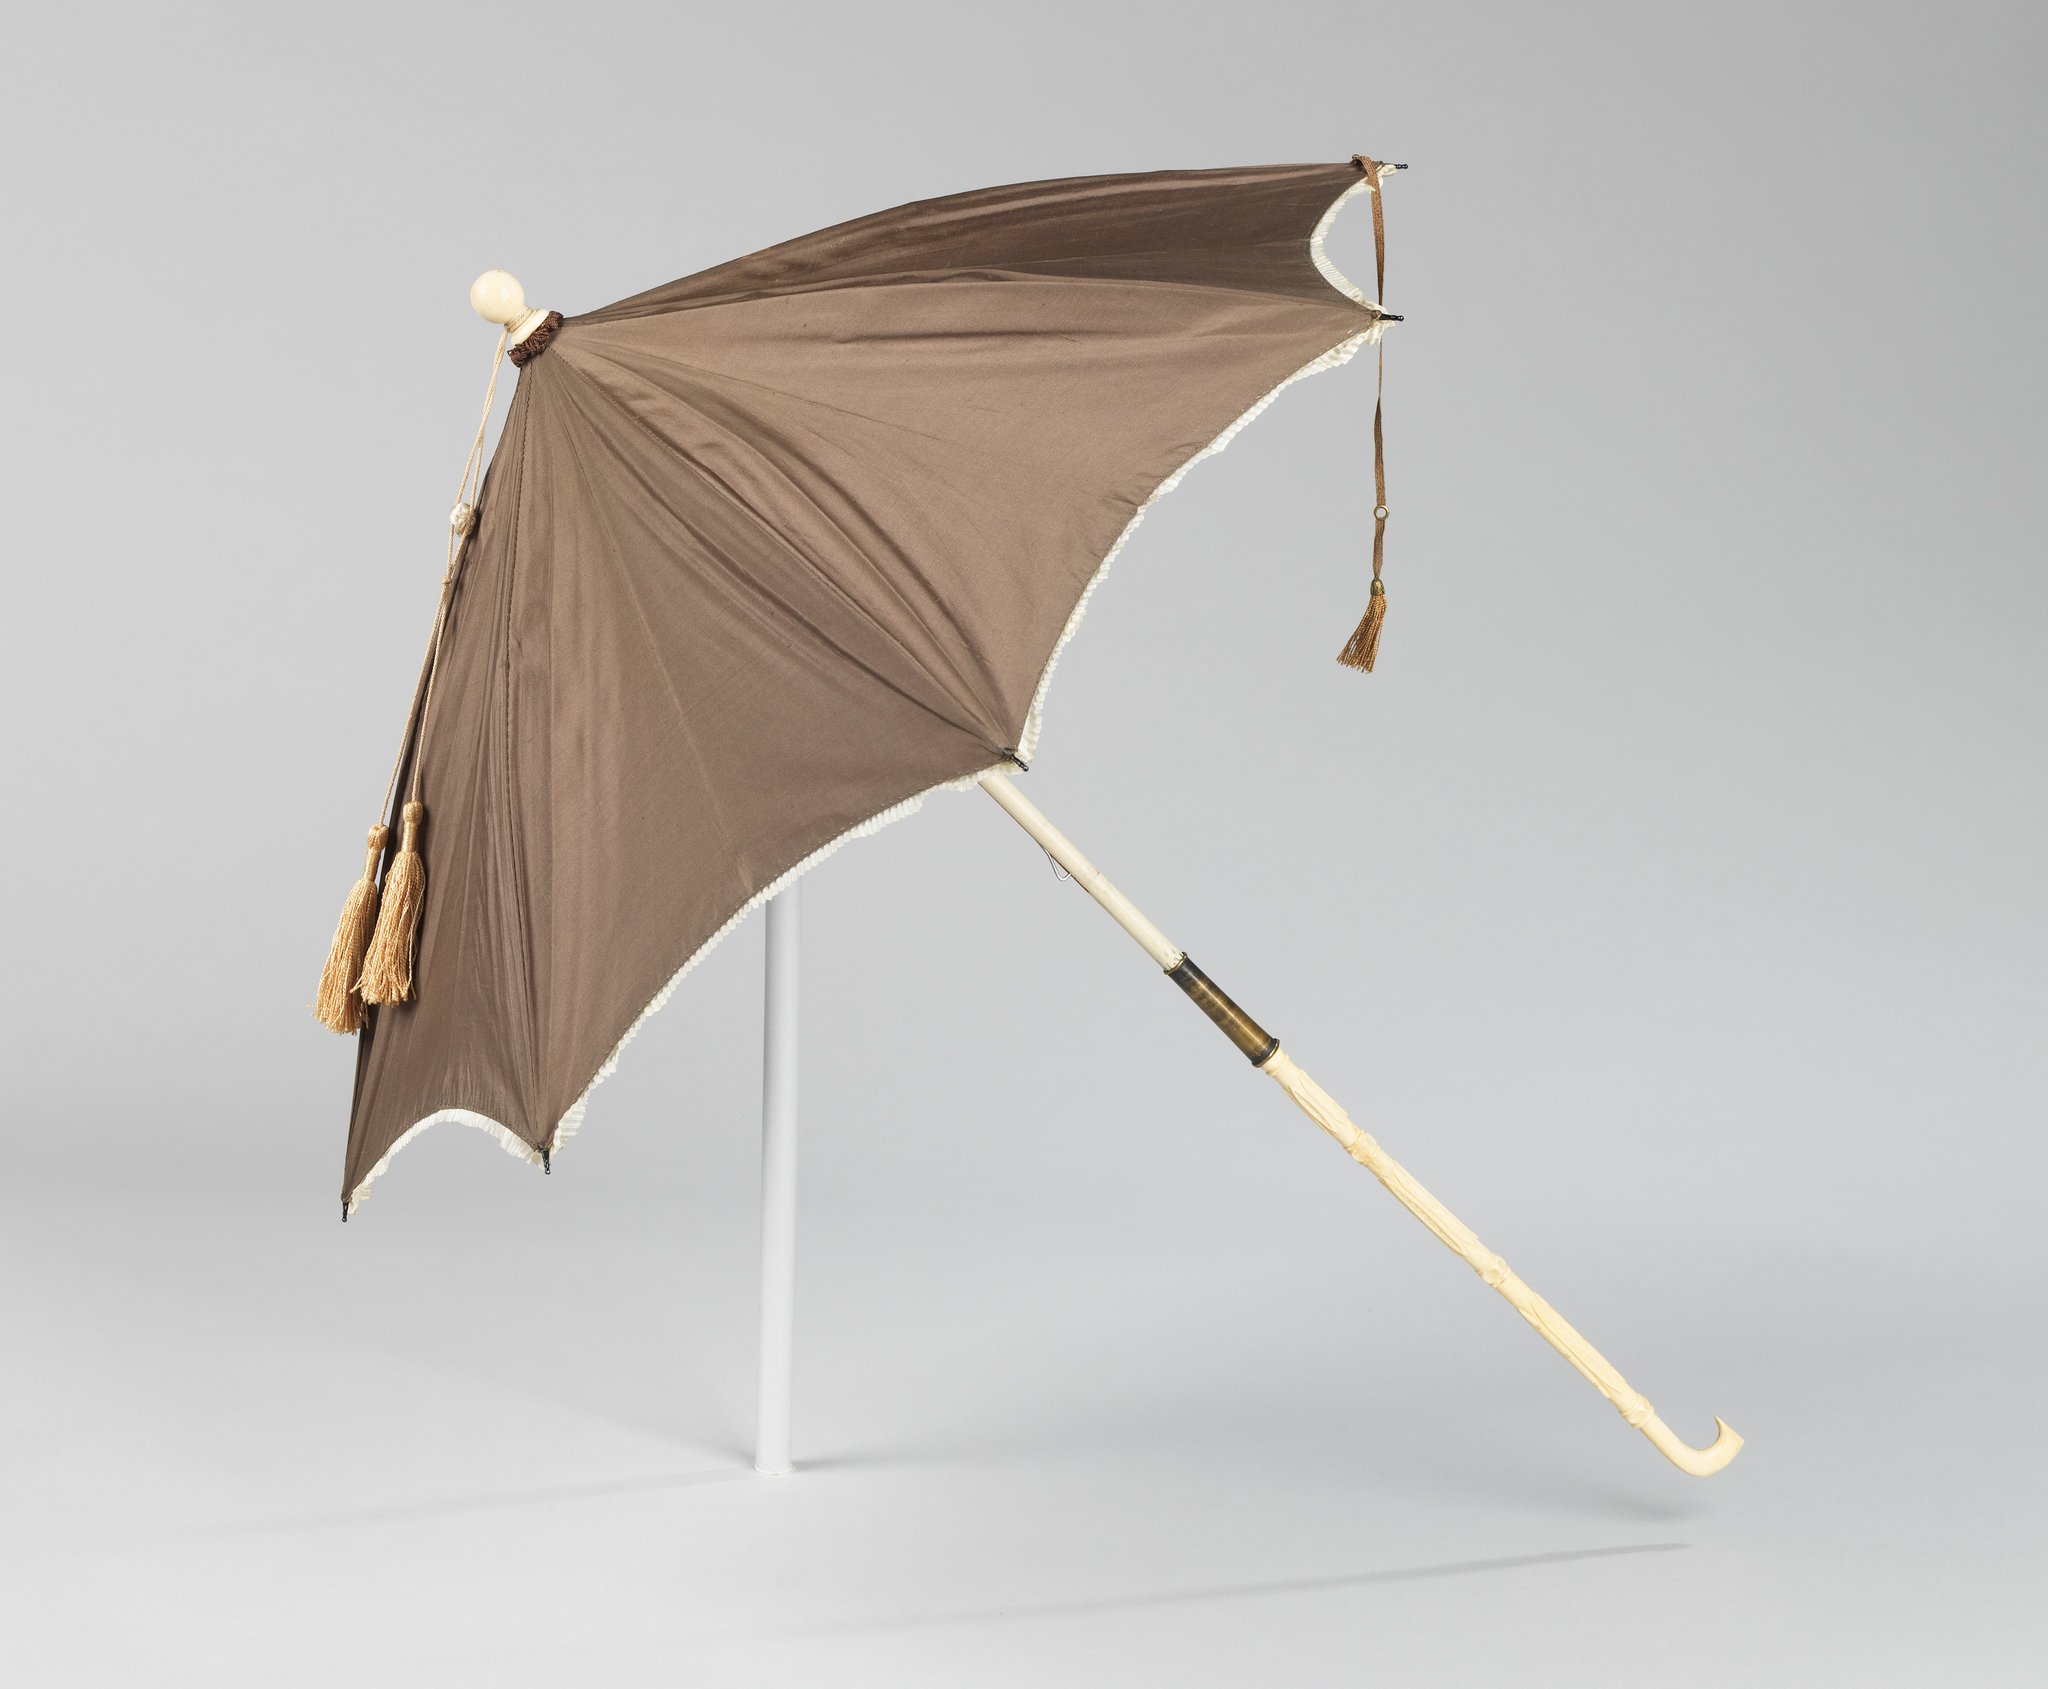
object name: parasol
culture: american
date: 1850-1869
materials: ivory, metal, silk, wood